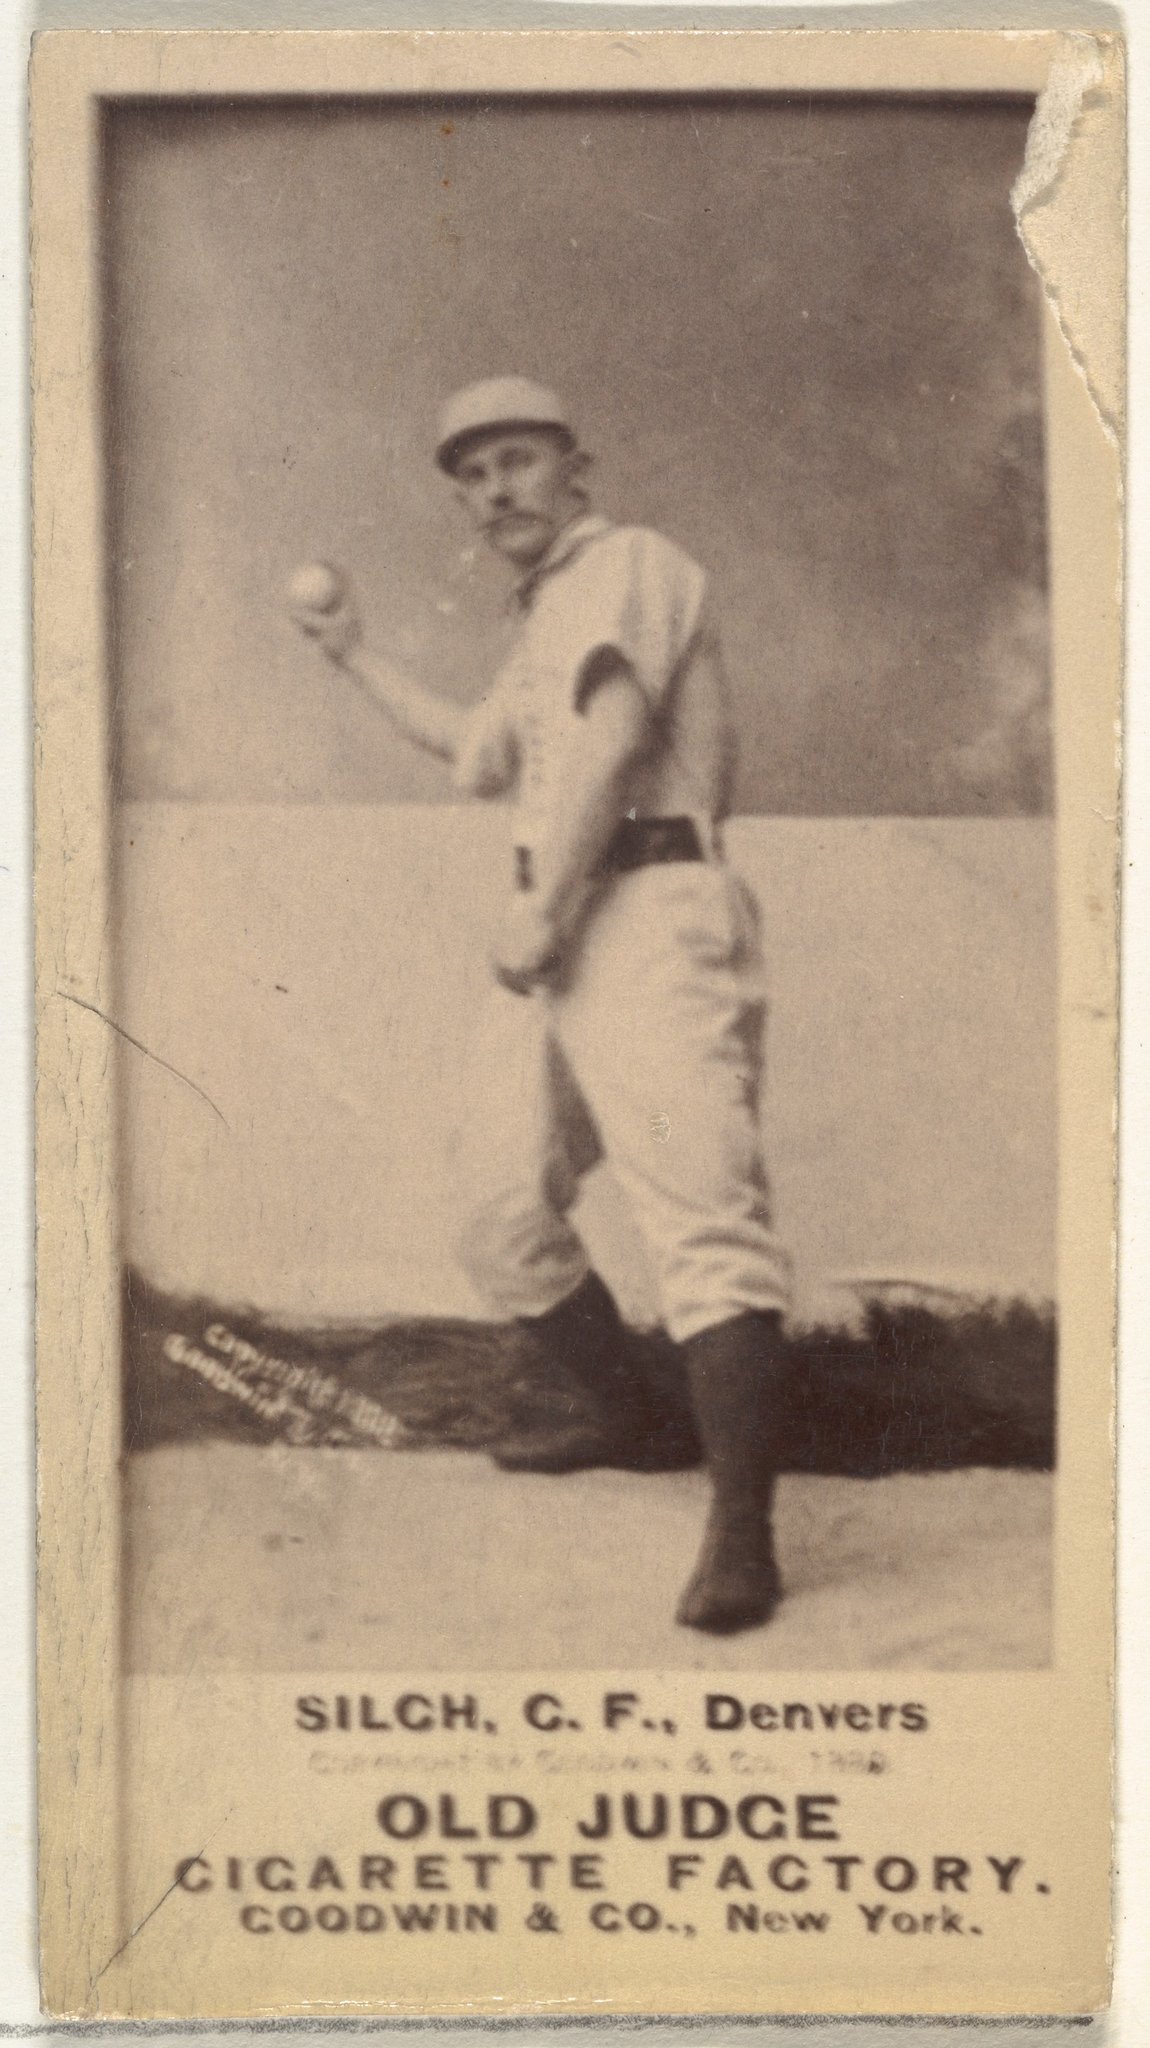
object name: baseball card, photograph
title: Ed "Baldy" Silch, Center Field, Denver, from the Old Judge series (N172) for Old Judge Cigarettes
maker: goodwin & company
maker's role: publisher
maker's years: 1850-1950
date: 1888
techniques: albumen silver print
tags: men,portraits,baseball,athletes